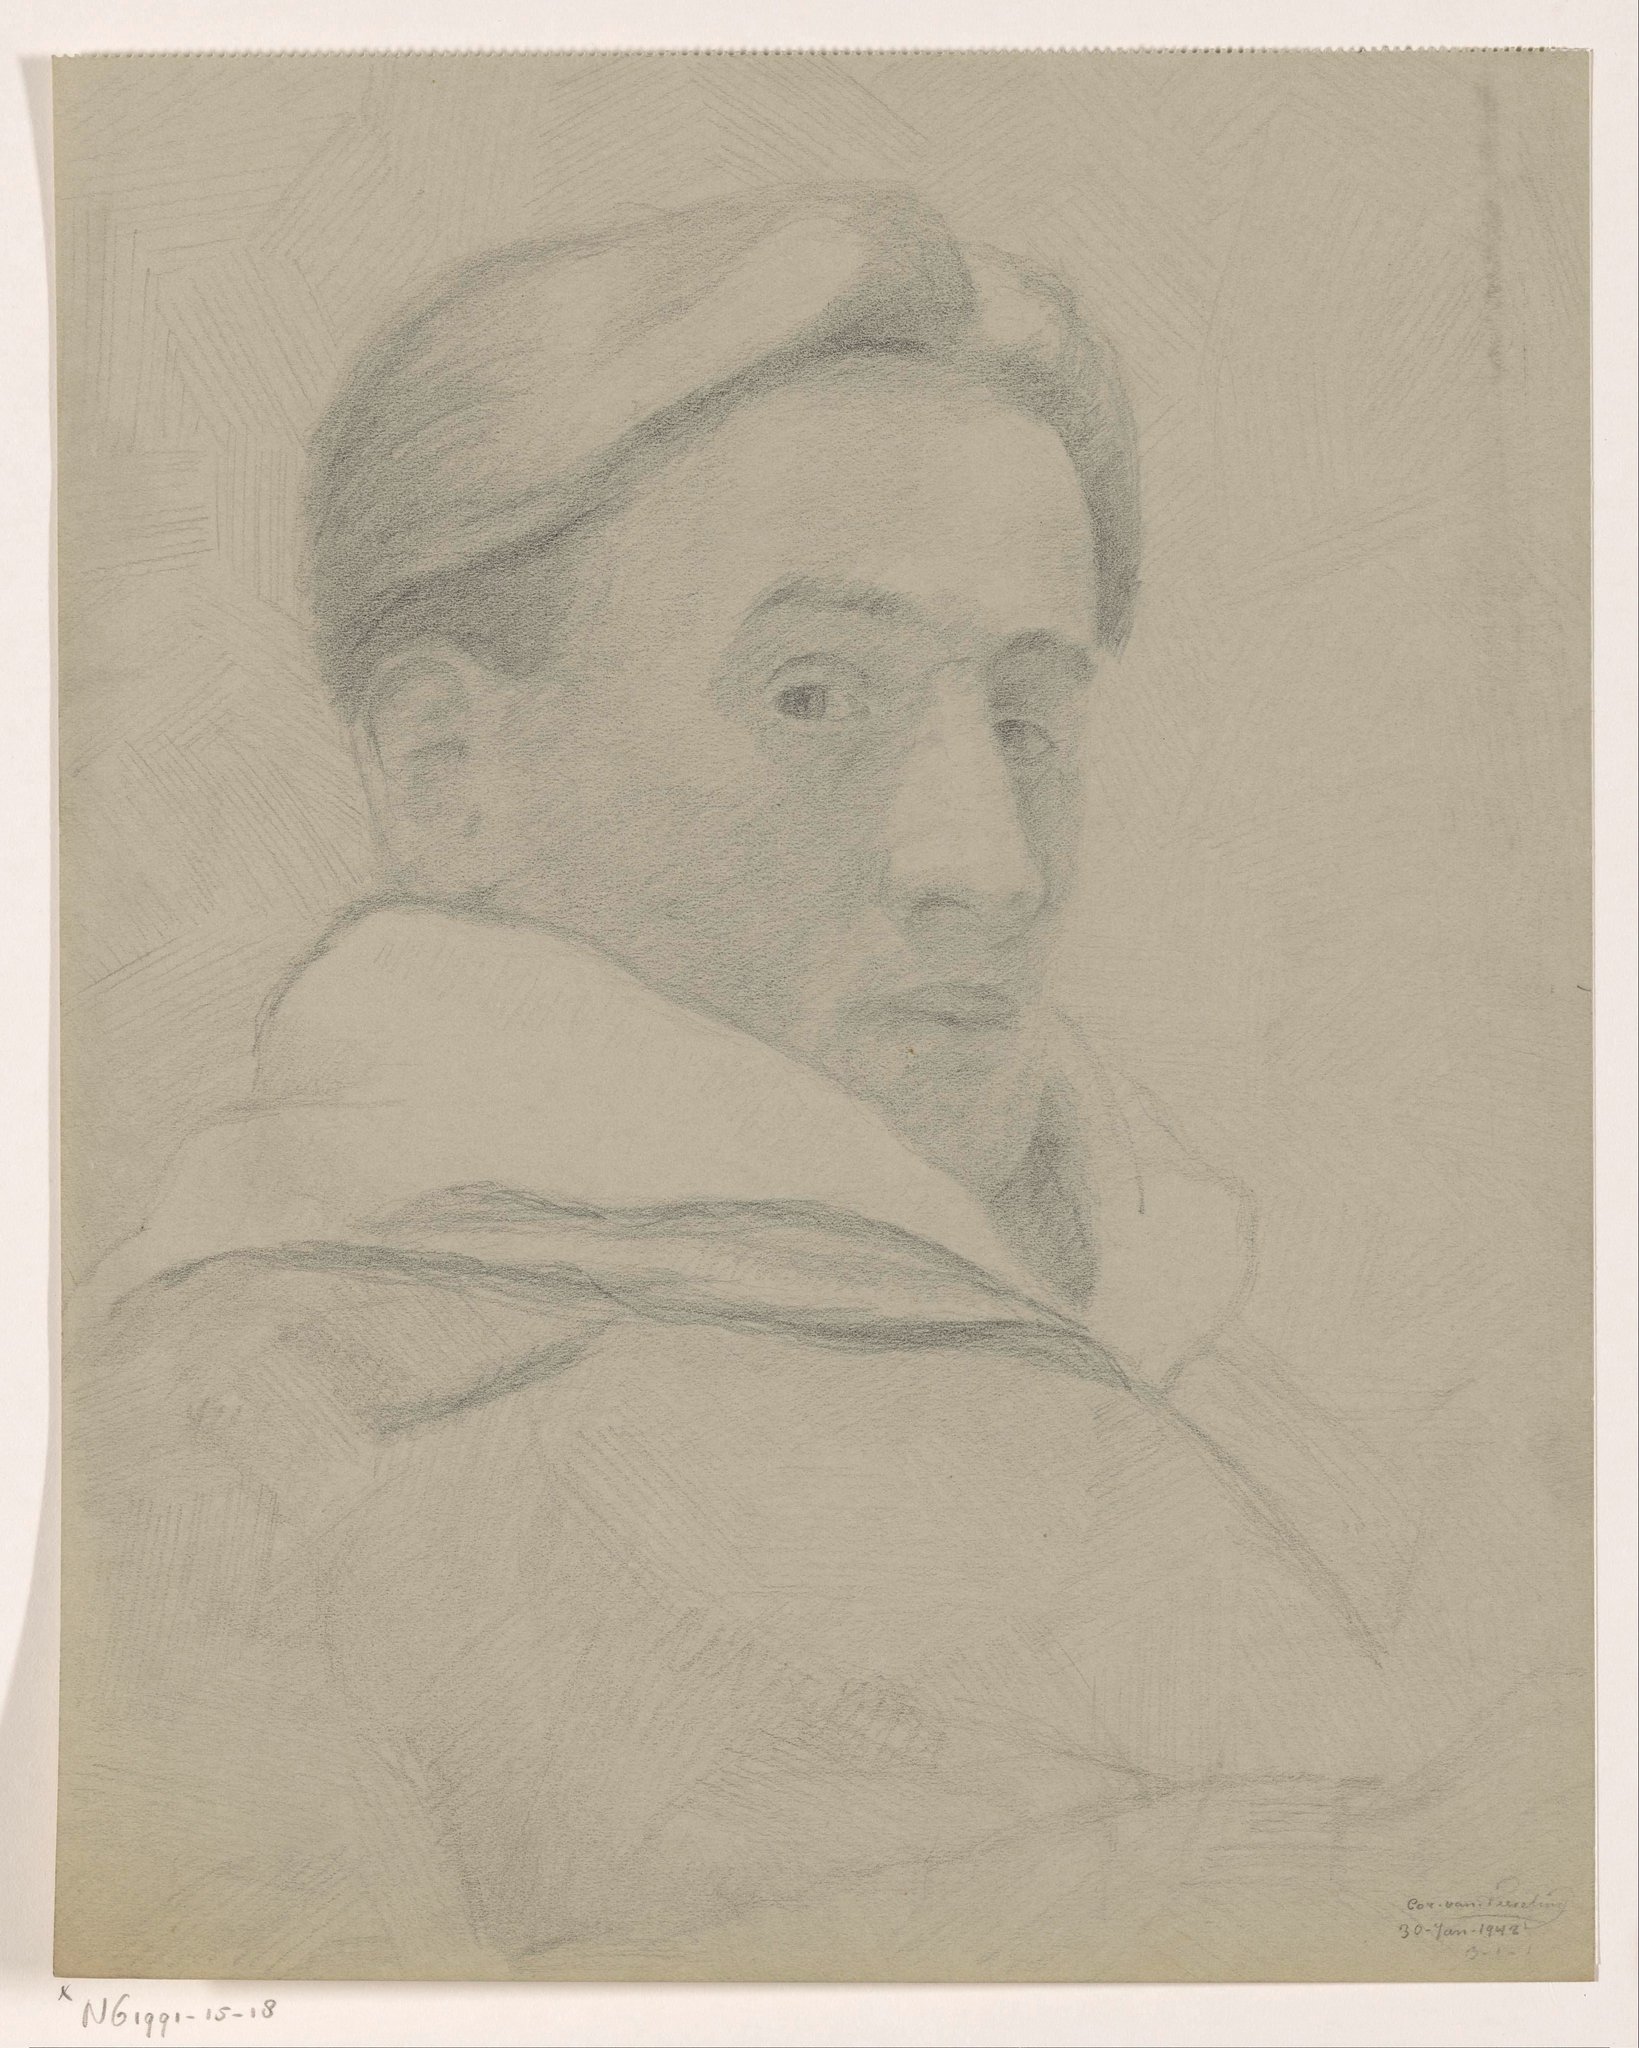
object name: drawing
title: Zelfportretten van Cor van Teeseling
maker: cor van teeseling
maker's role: draughtsman, sculptor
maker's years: 1915-1942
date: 1942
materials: paper, pencil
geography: weteringschans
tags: amsterdam, draughtsman, sculptor, cor van teeseling, historical persons, prisoner in cell or locked place, portrait, self-portrait of draughtsman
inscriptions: signature and date: ‘30 Jan 1942 / Cor van Teeseling / B-1-1’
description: Zelfportret van Cor van Teeseling: in de gevangenis aan de Weteringschans, cel B-1-1, 30 januari. Getekend zelfportret van Cor van Teeseling met zijn hoofd naar rechts gewend.